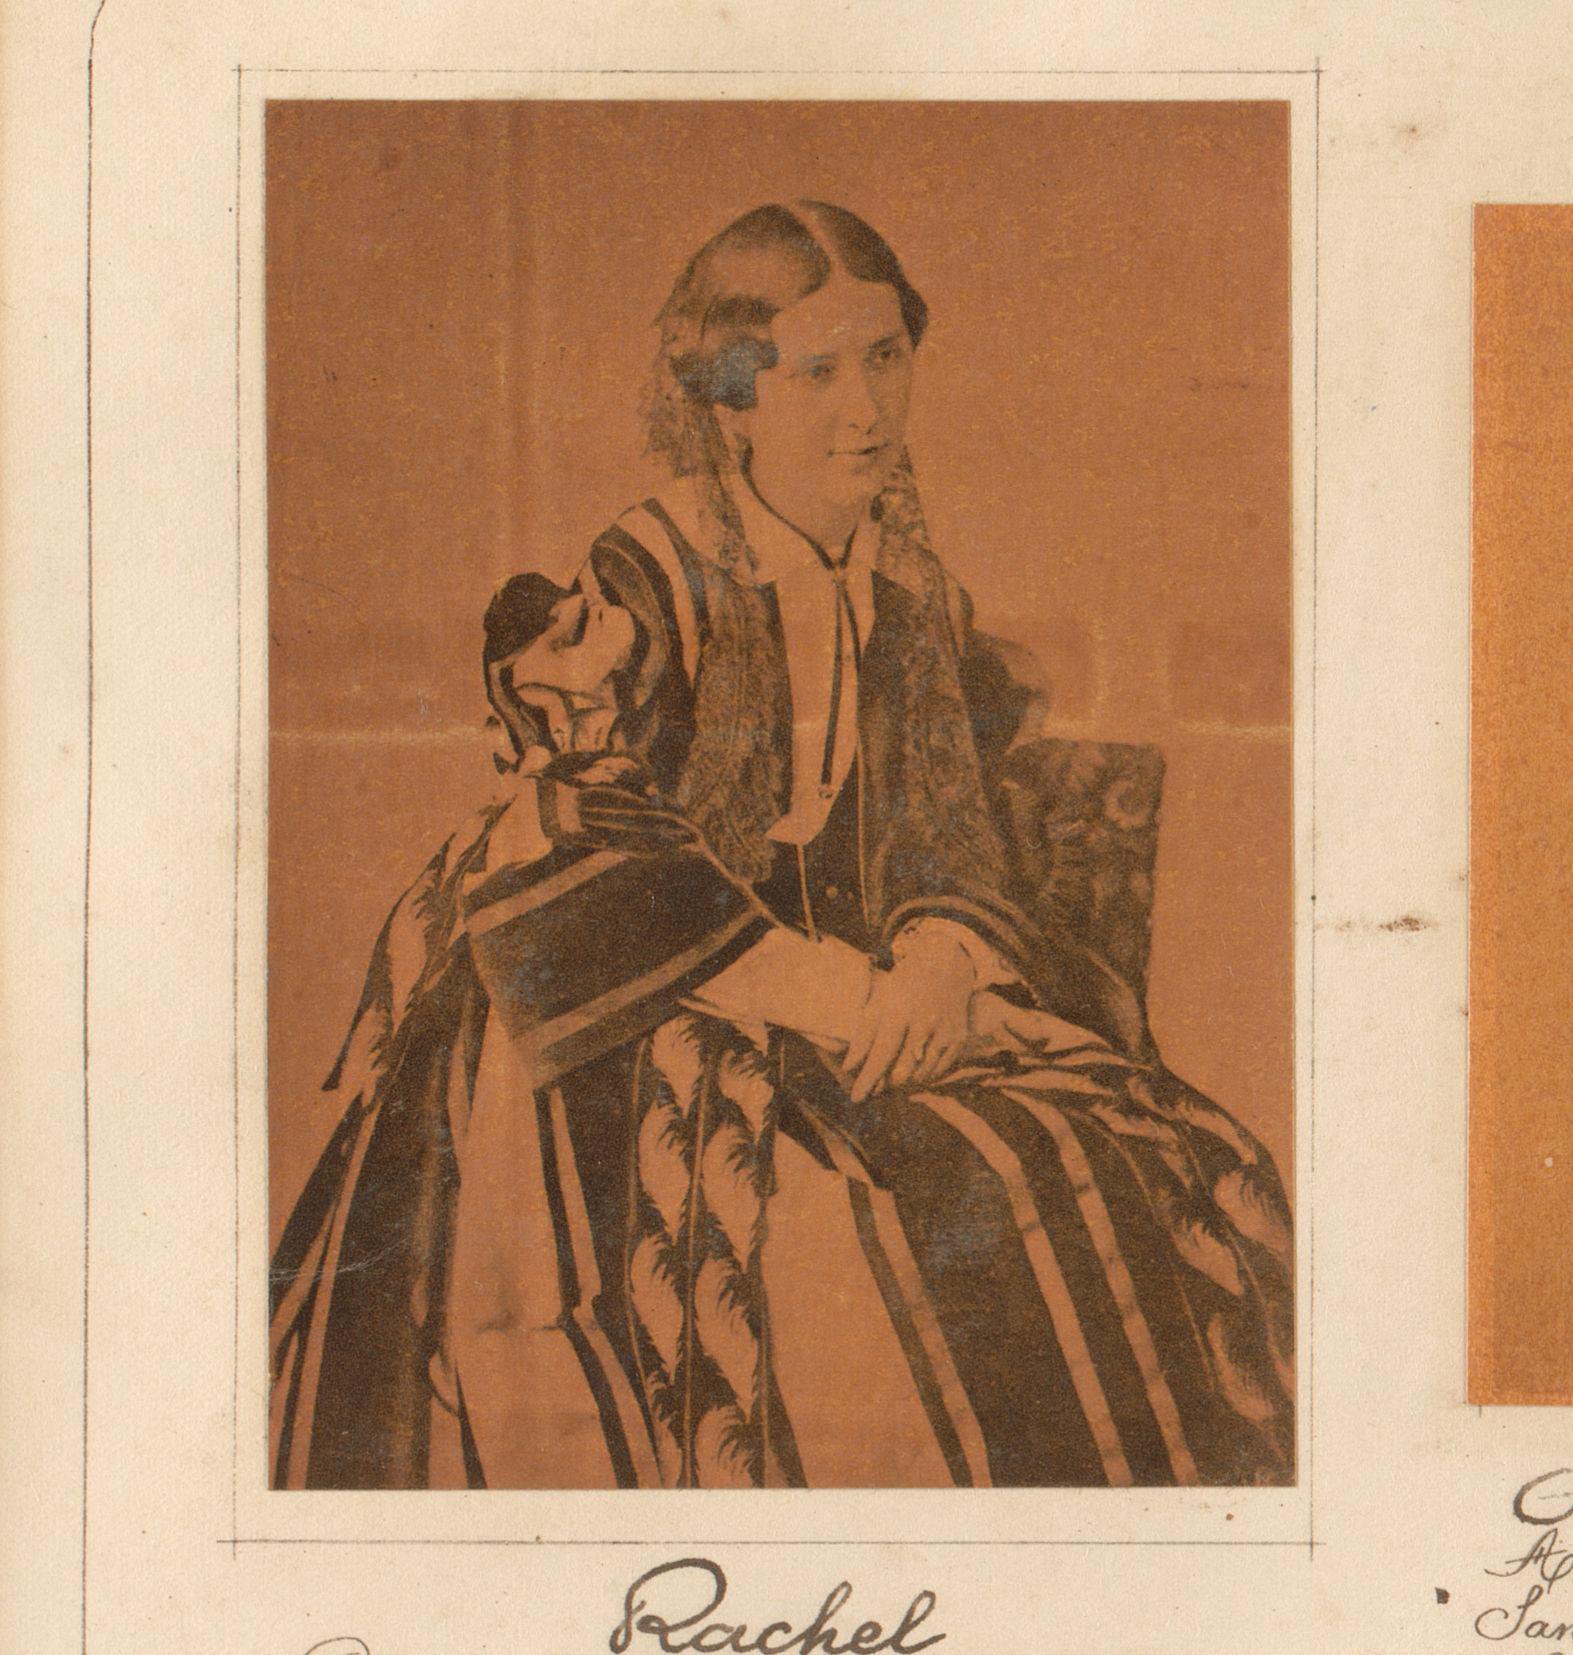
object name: photomechanical print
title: Portret van Elizabeth-Rachel Félix, bekend als Mademoiselle Rachel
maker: Anonymous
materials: paper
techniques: rotogravure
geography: france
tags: portrait of actor, actress, france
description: Deze prent maakt deel uit van een album.